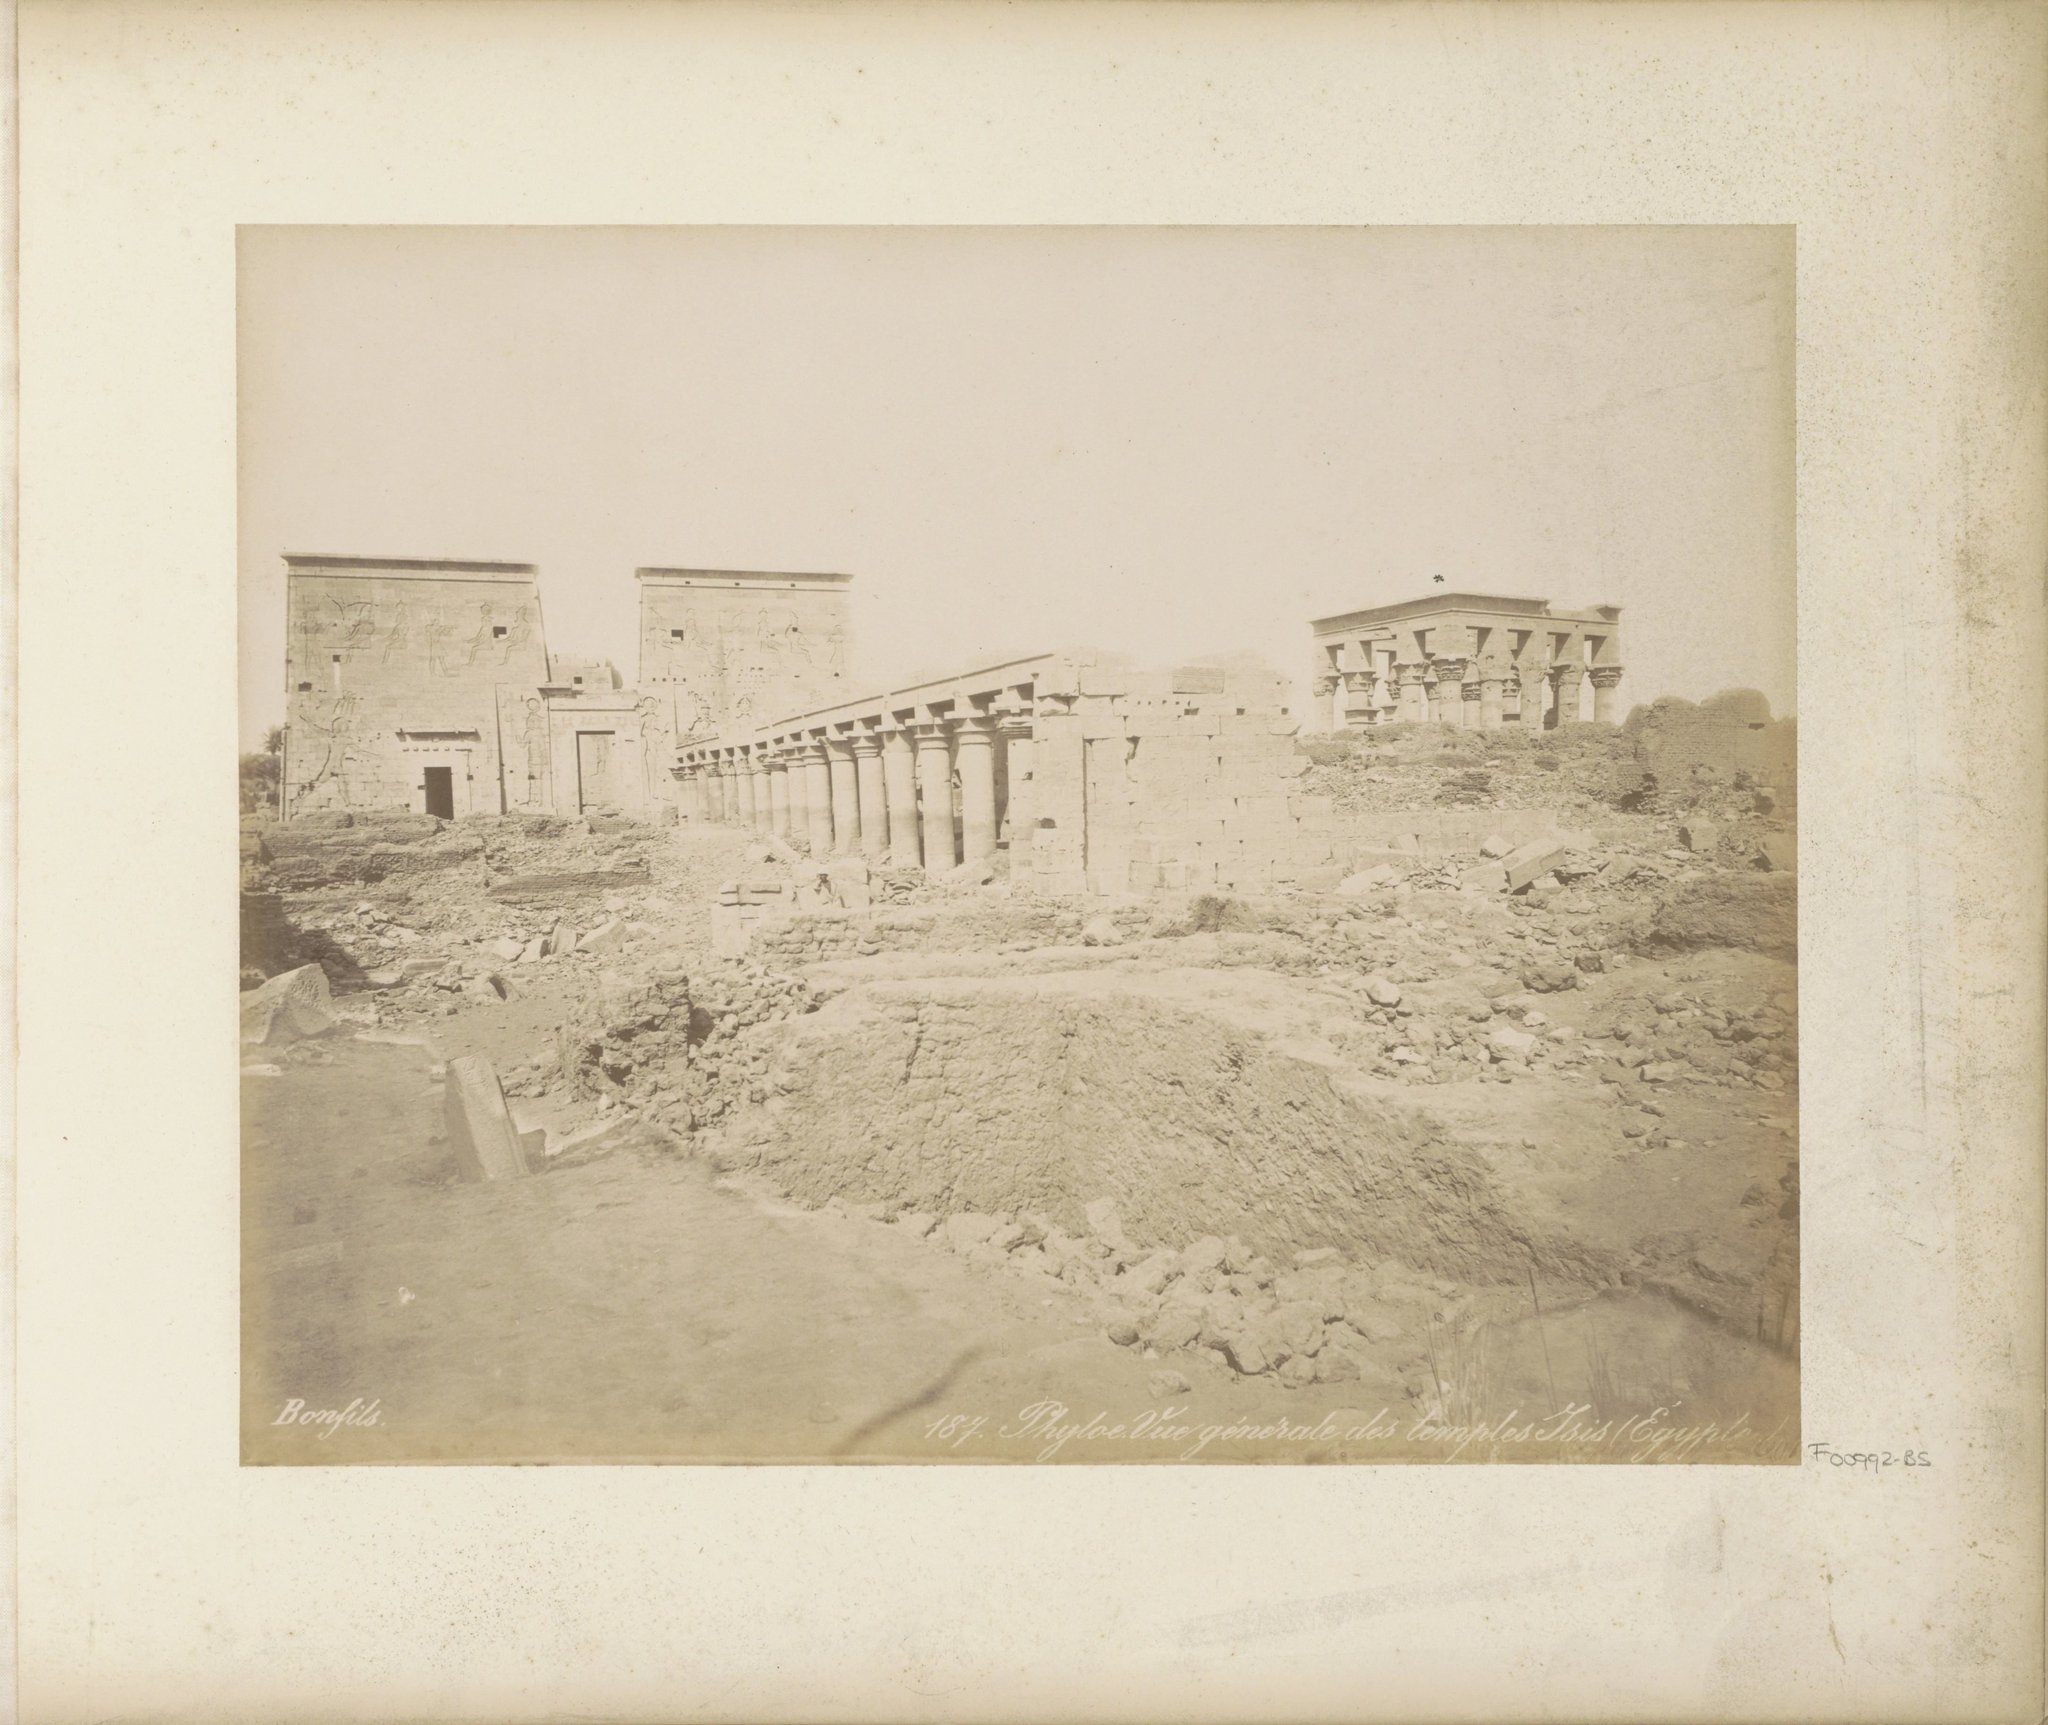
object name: photograph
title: Phyloe. Vue générale des temples Isis (Égypte)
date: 1870-1898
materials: cardboard, paper, photographic support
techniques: albumen print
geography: philae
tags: temple, shrine ~ egyptian religion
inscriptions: negative number: ‘187’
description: De Tempels van Isis op Philae zijn tussen 1977 en 1980 verplaatst naar het eiland Agilkia ivm. de aanleg van de Aswandam.